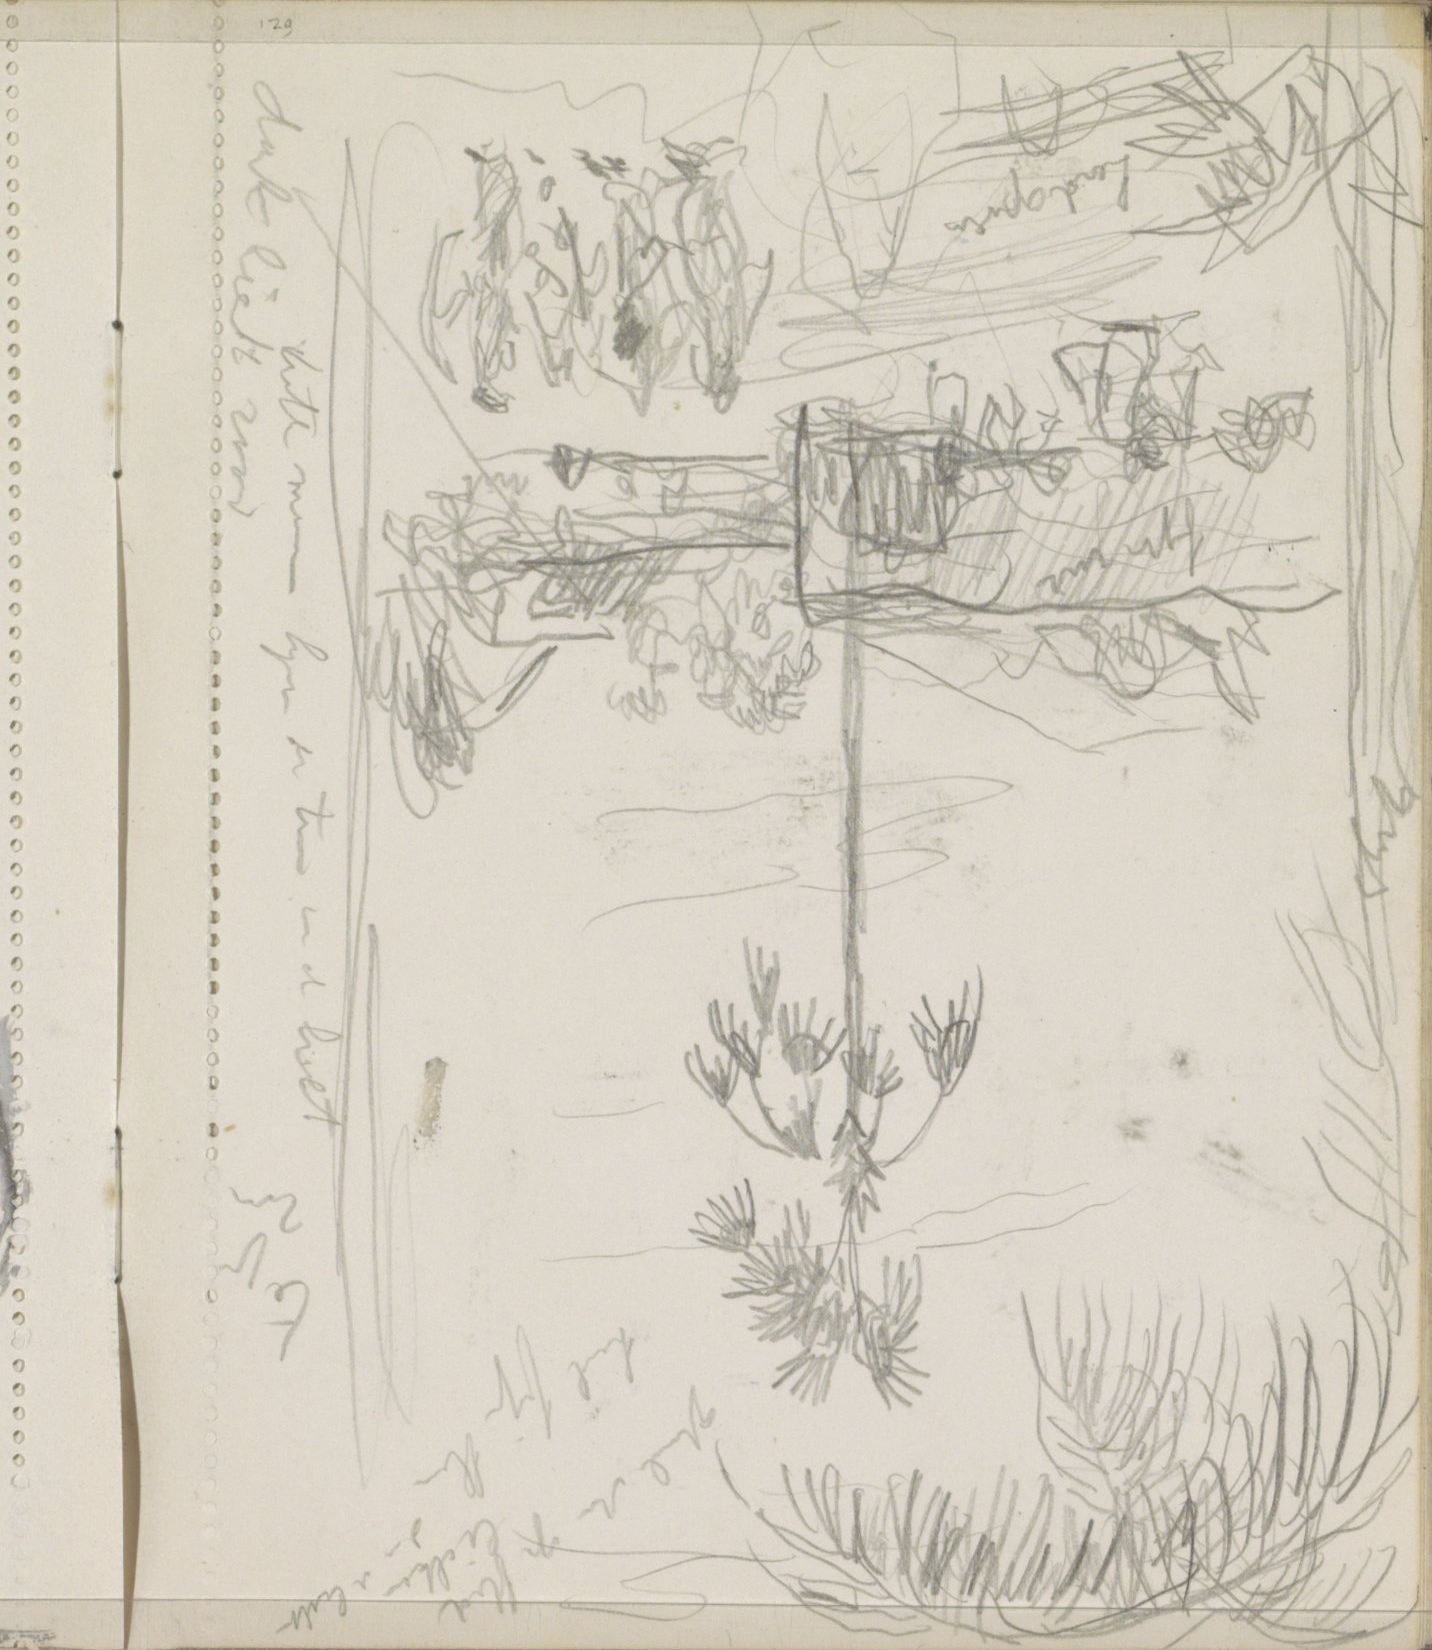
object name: sketchbook leaf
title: Heuvellandschap met palmbomen en figuren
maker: marius bauer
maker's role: draughtsman, print maker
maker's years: 1867-1932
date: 1925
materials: paper, pencil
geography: indonesia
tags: (high) hill, trees: palm-tree, landscapes (+ landscape with figures, staffage)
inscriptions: kleurnotitie, handgeschreven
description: Pagina 129 uit een schetsboek met 67 bladen.